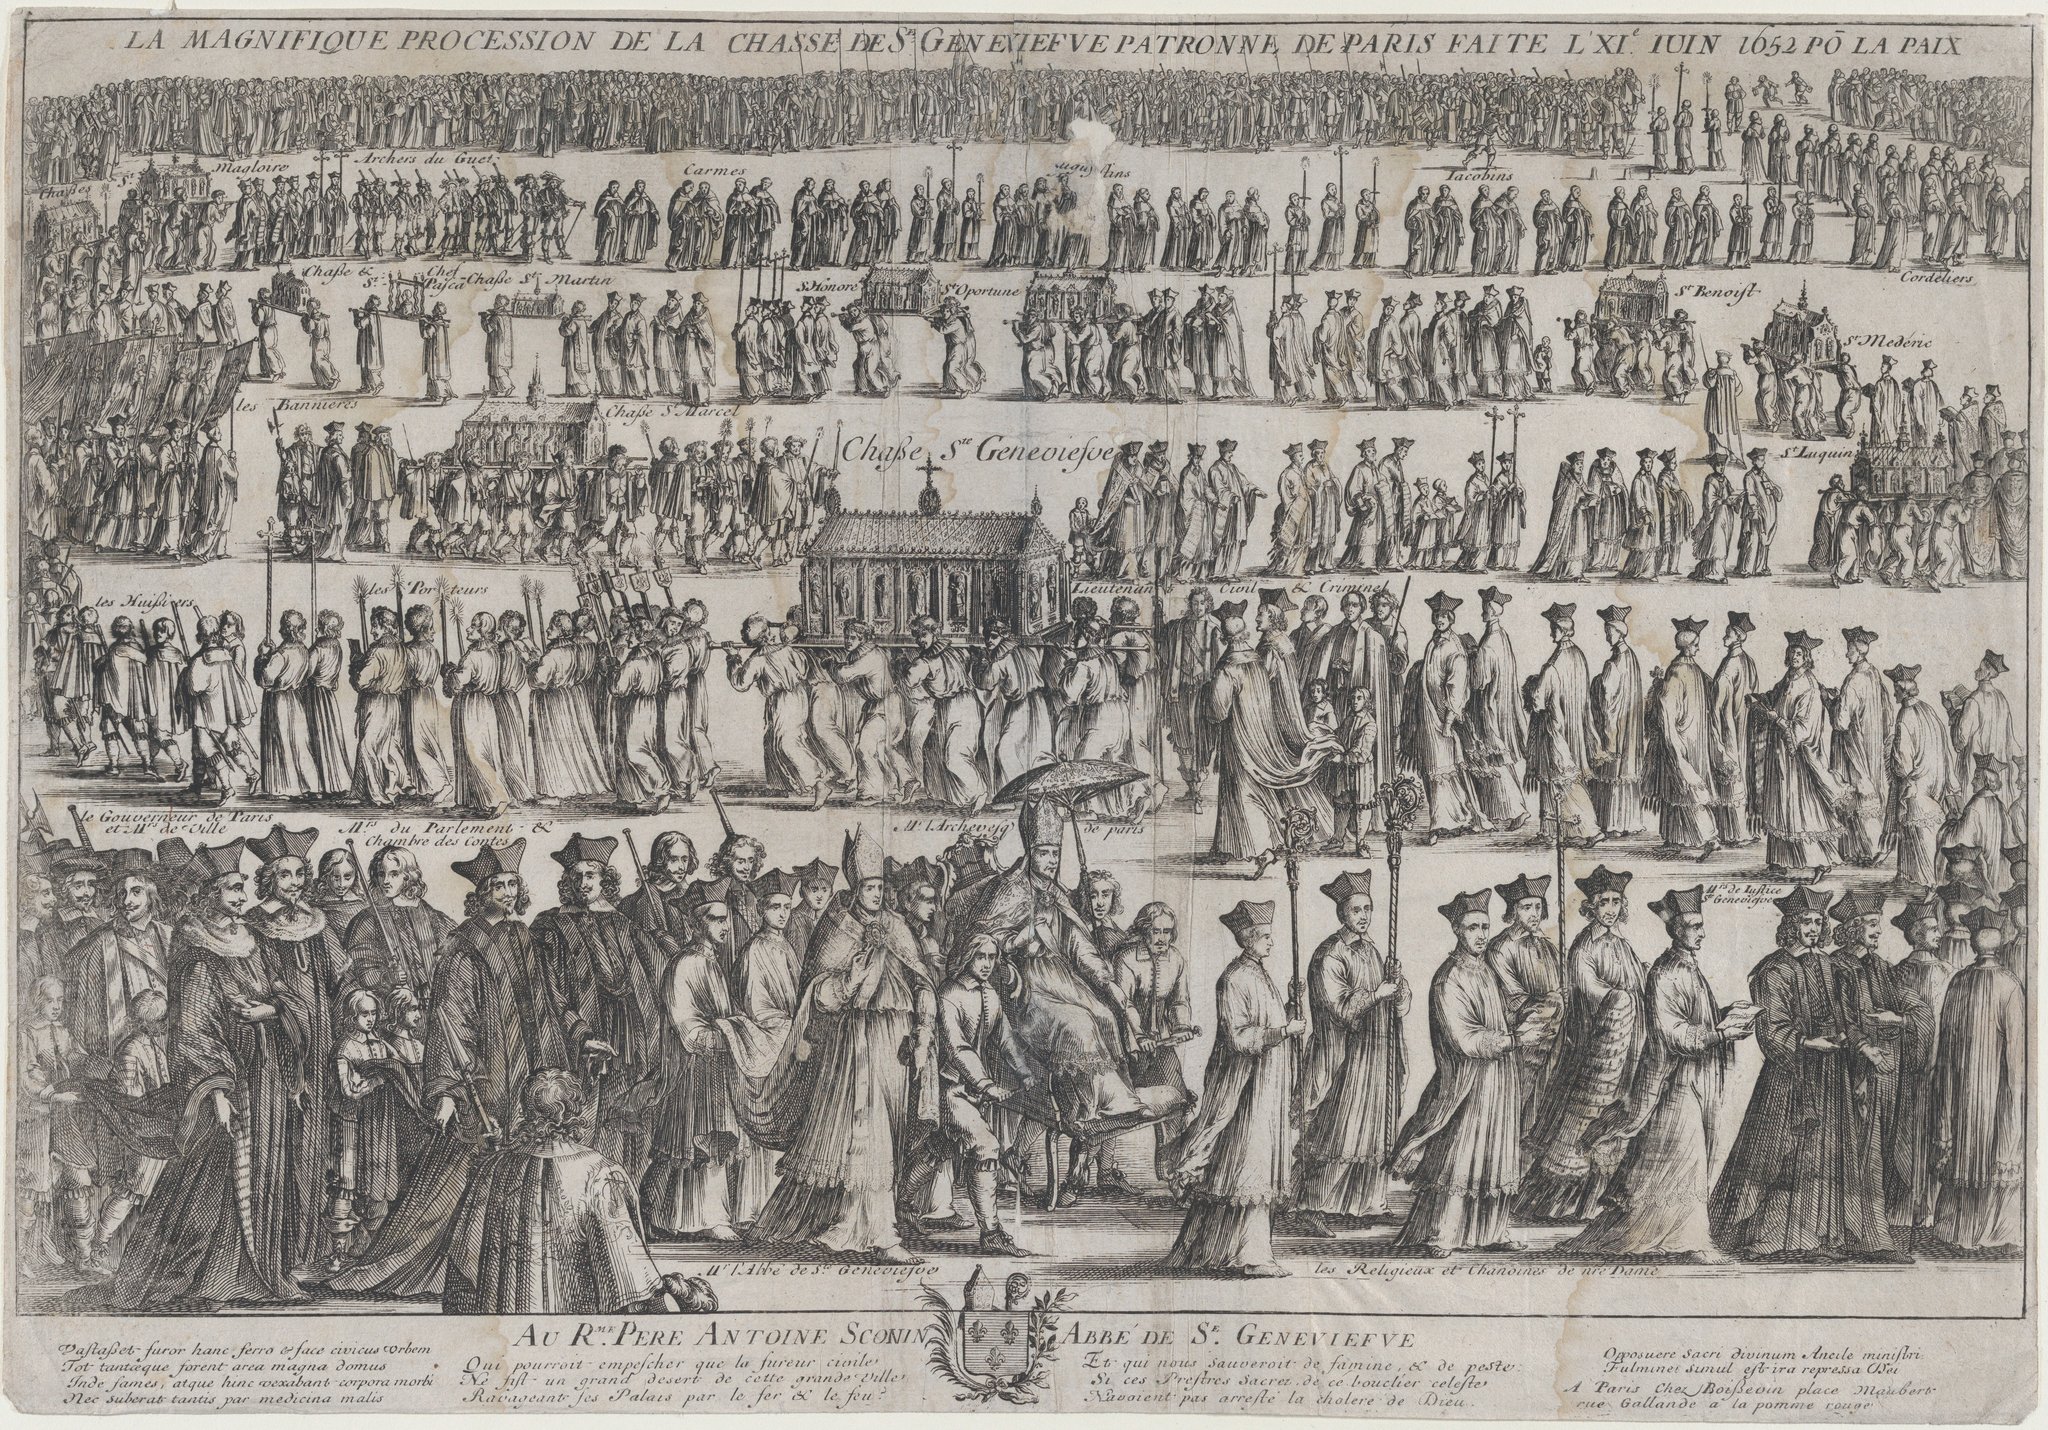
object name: print, fete, ornament architecture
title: The procession of the casket of St. Genevieve, with clerics and laymen marching in six rows; in the foreground the Archbishop of Paris is carried in a chair, the Chasse in the row above him, and the monks of the monasteries of Paris lead the procession at top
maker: nicolas cochin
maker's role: artist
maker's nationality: french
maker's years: 1610-1686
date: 1652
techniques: etching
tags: men,bishops,monks